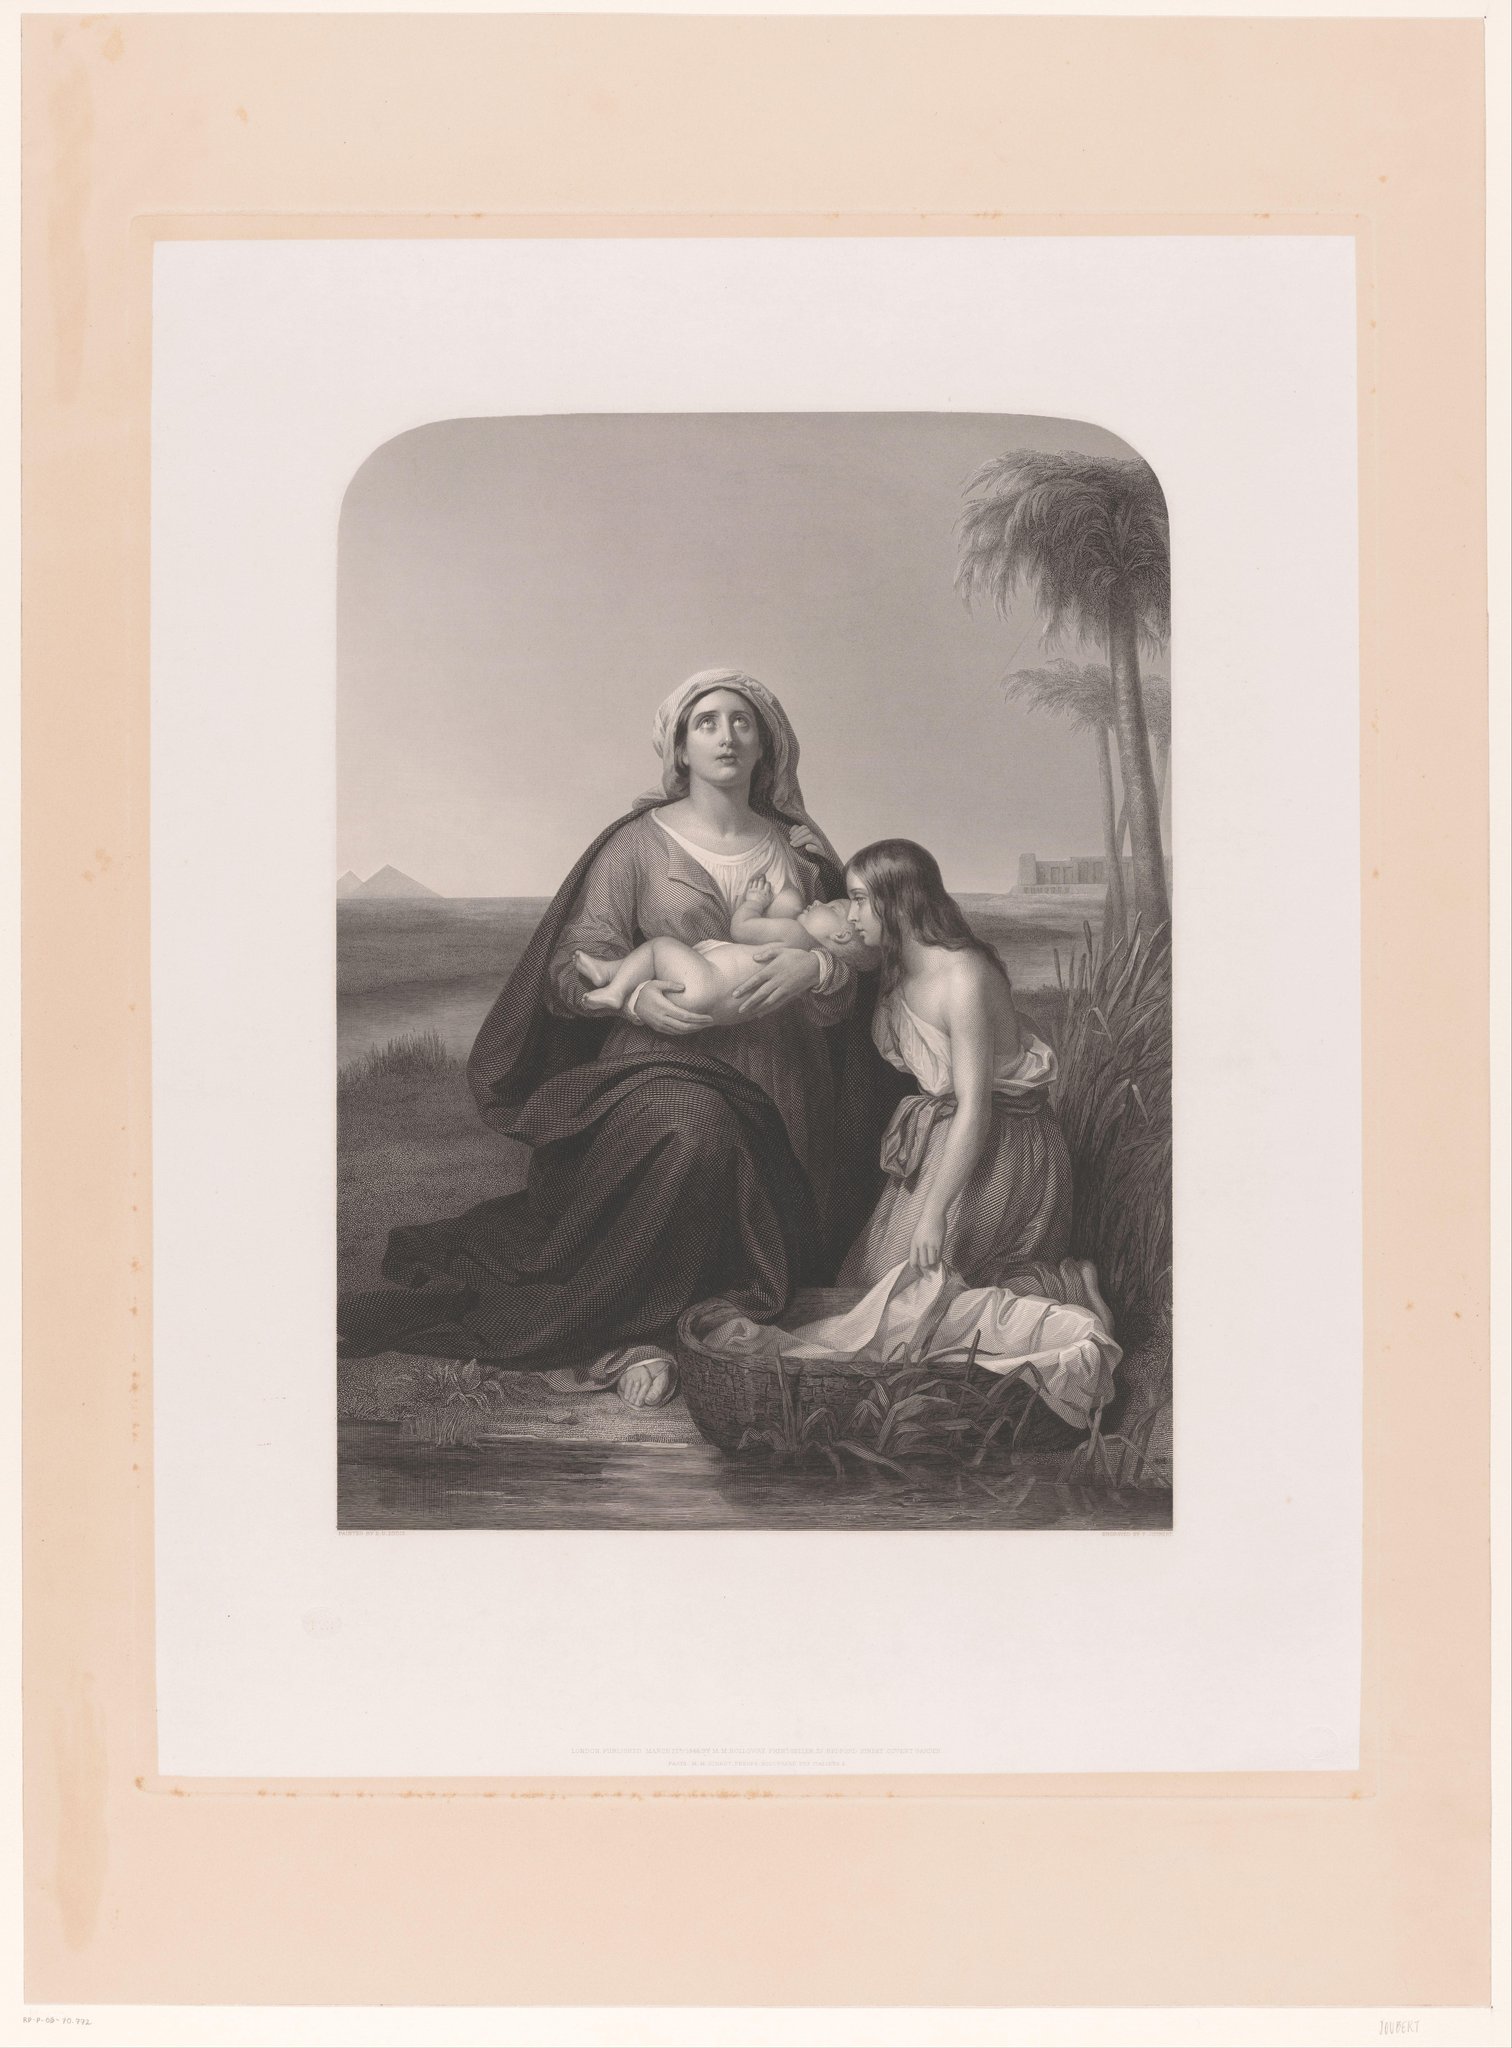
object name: print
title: Mozes wordt gezoogd aan de Nijl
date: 1848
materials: paper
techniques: engraving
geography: paris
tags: feeding a baby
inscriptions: check stamp, check stamp: ‘TVN’ Lugt 2050, collector's mark: Lugt 12